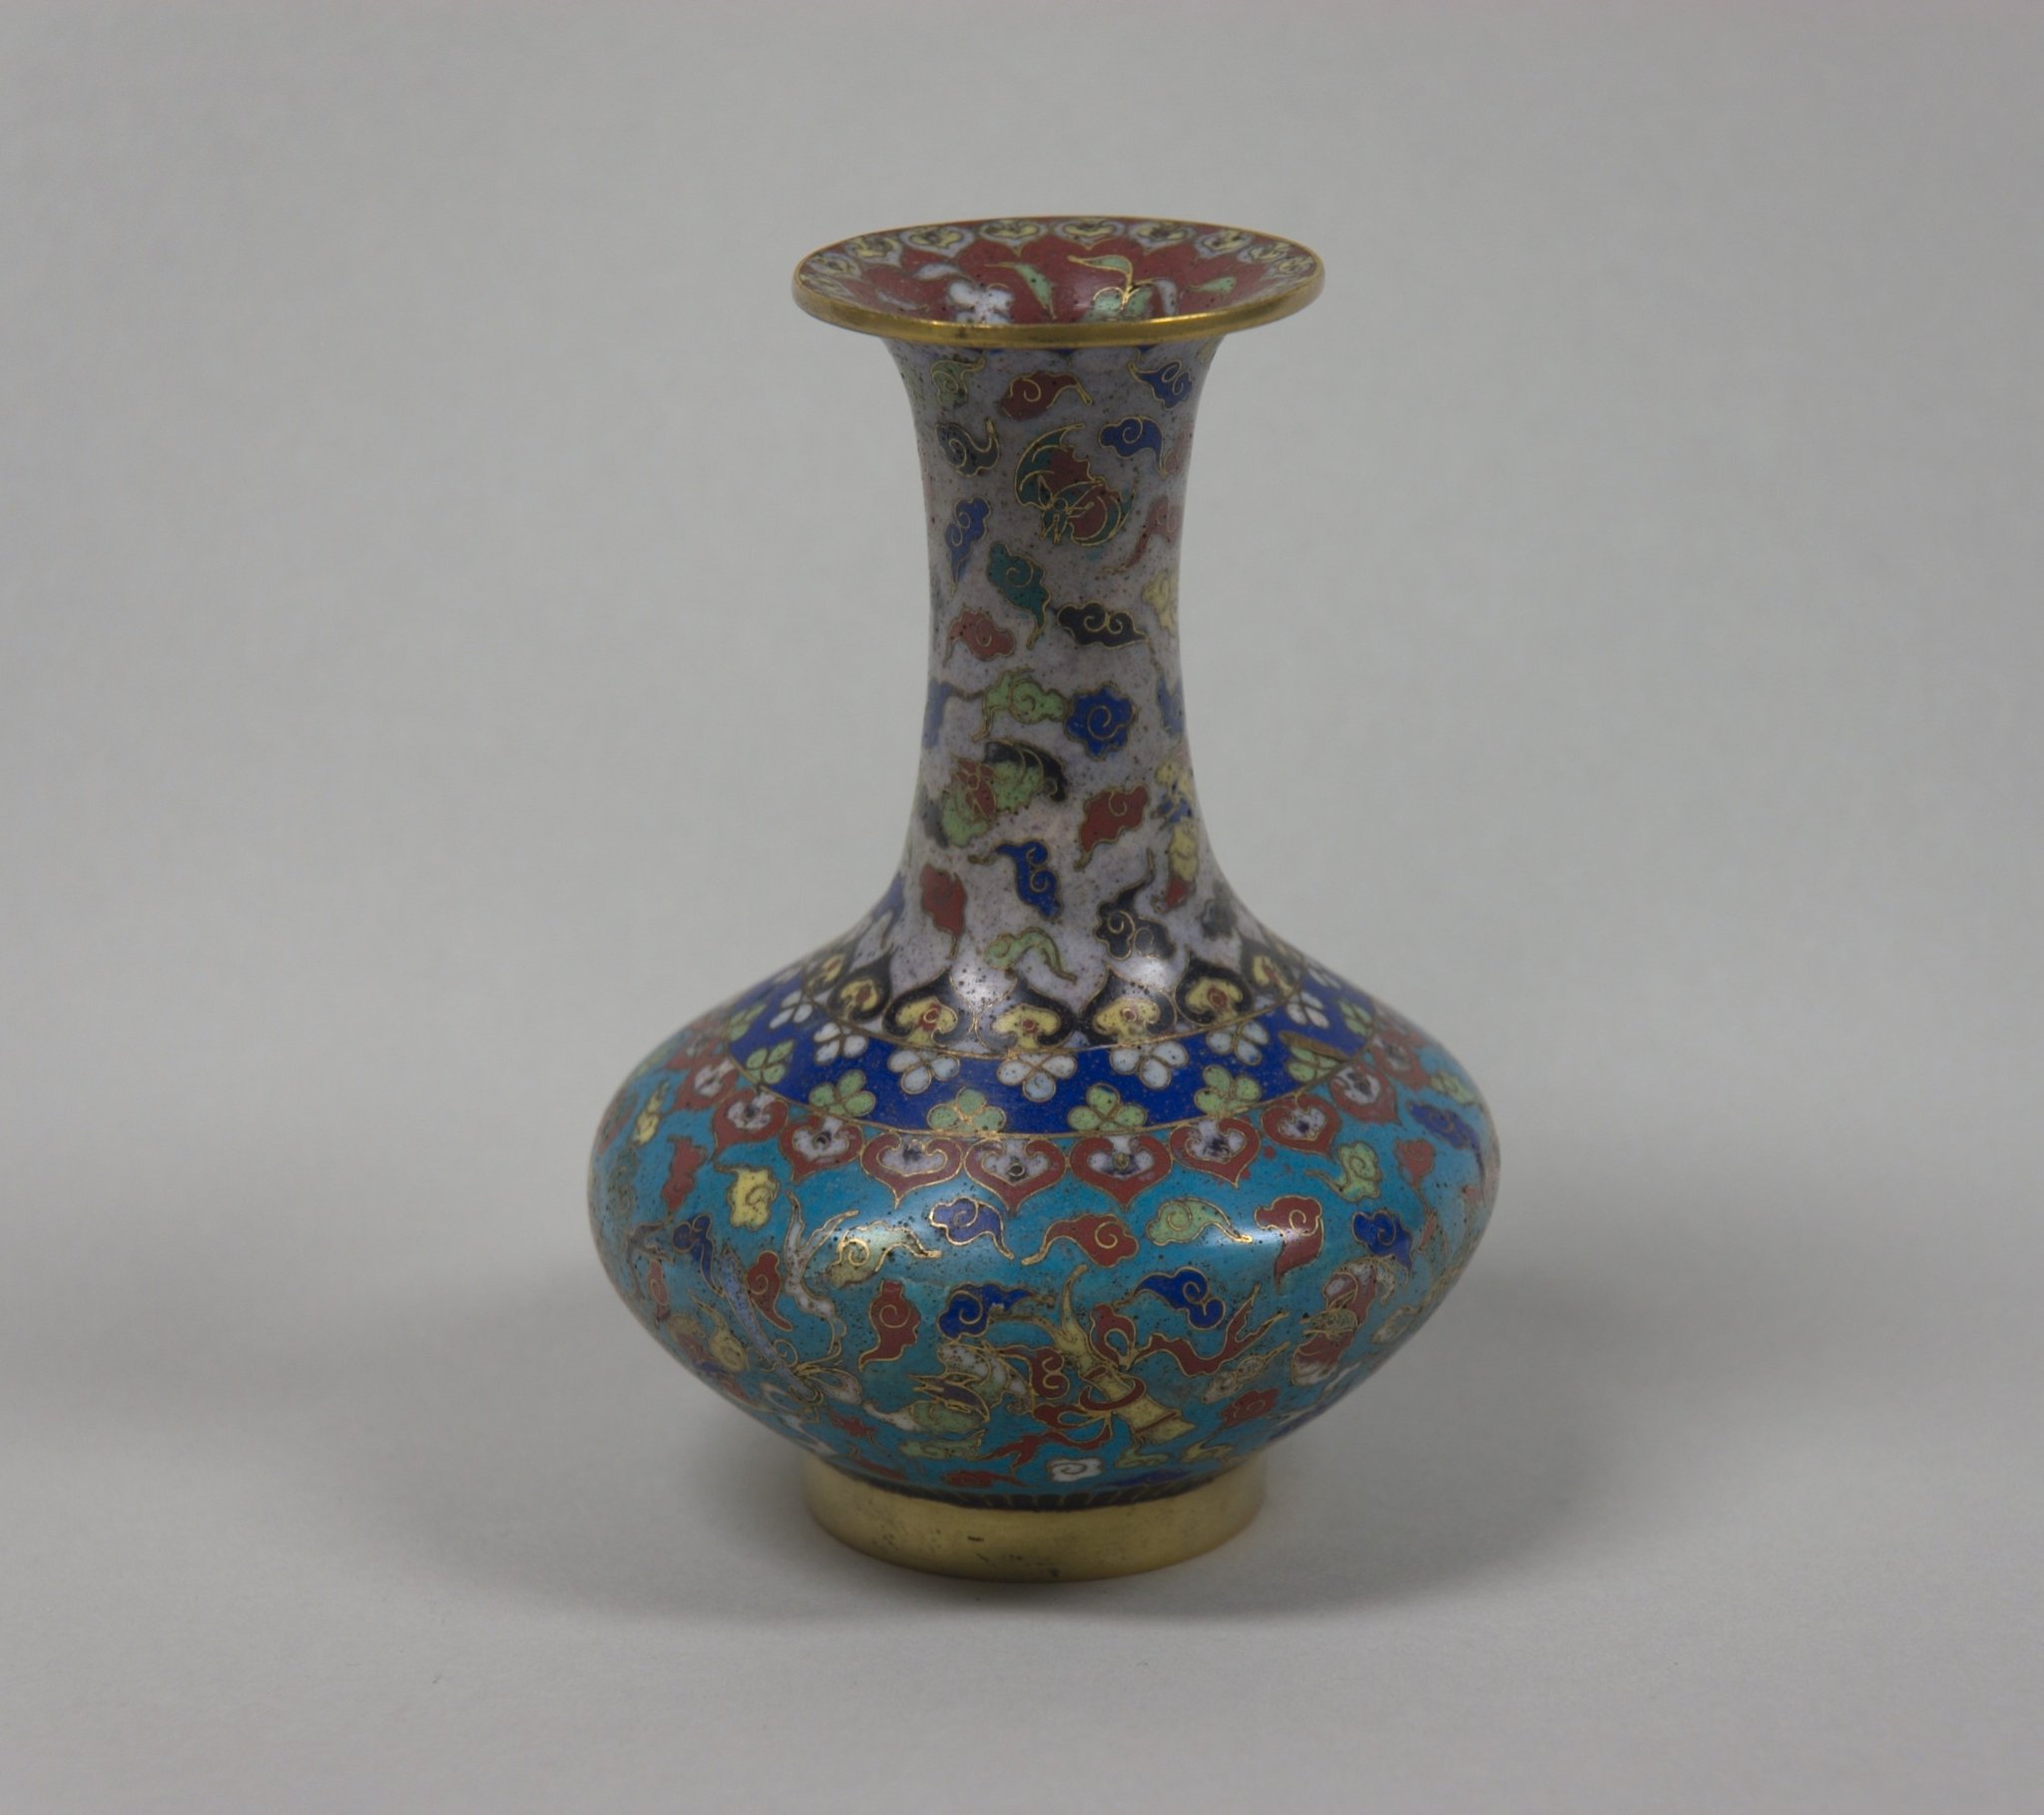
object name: vase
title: Small Vase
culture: chinese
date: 1801-1900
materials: enamel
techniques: enamel